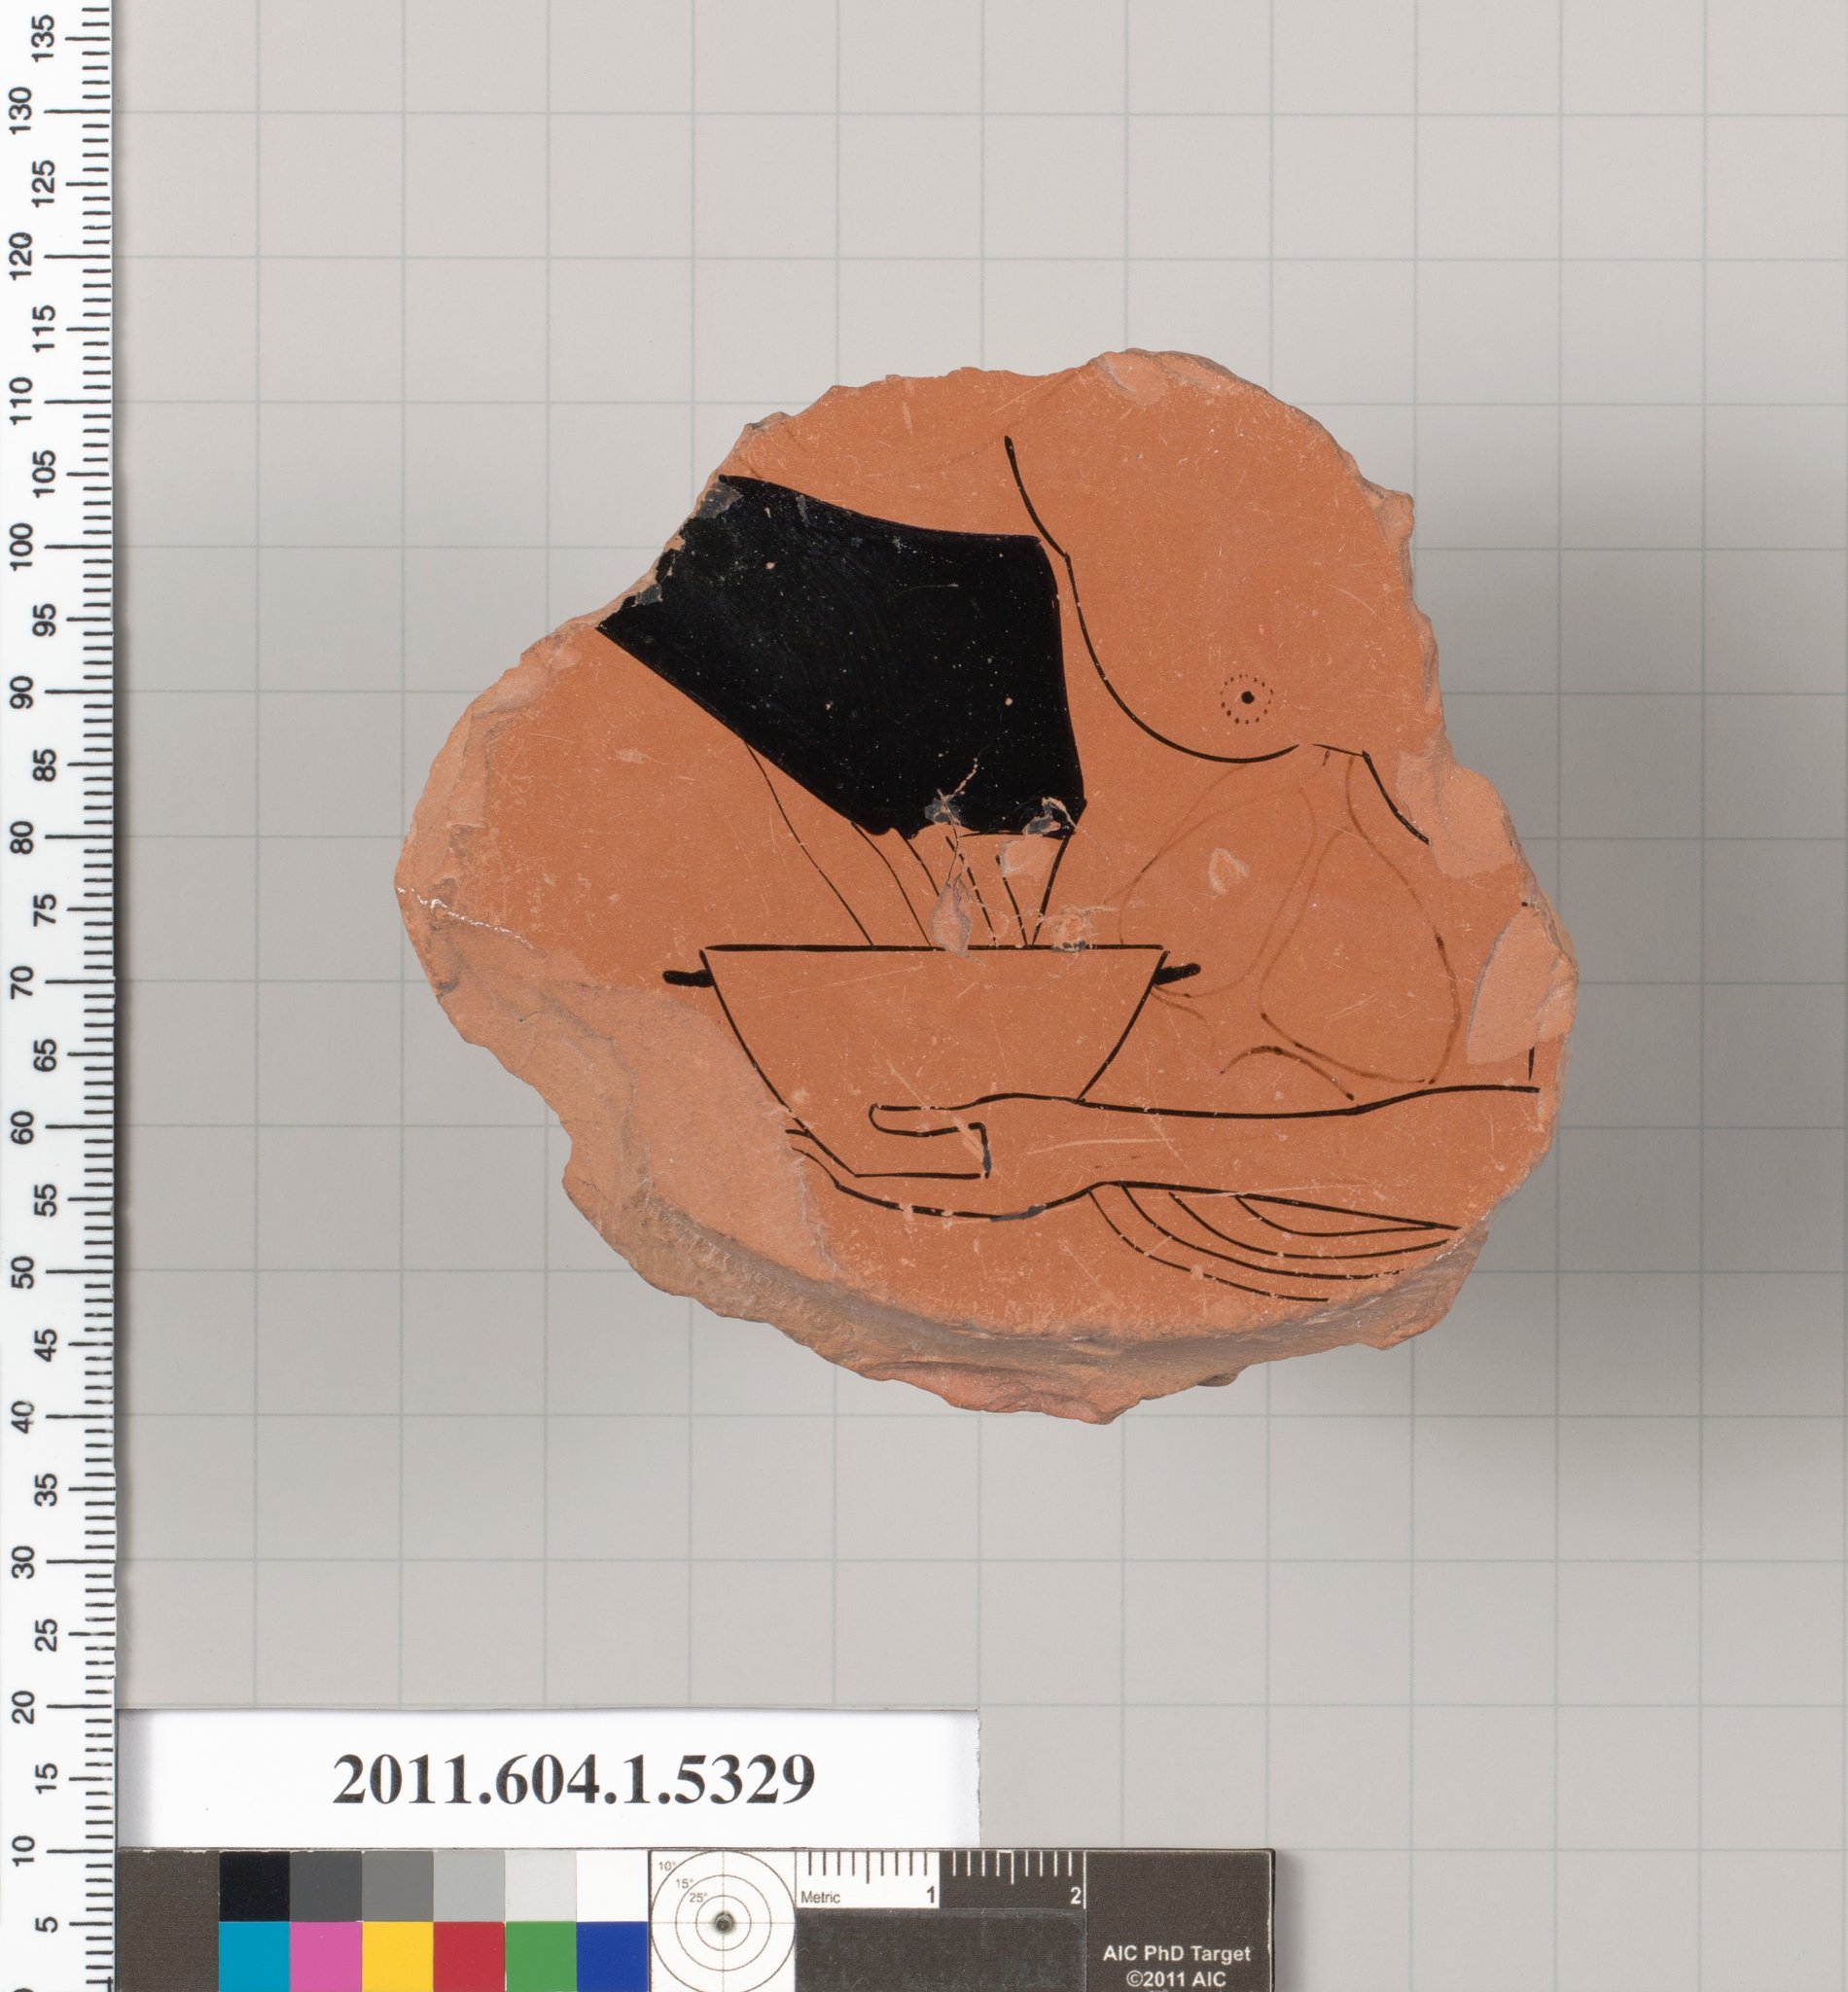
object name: kylix fragment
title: Terracotta fragment of a kylix (drinking cup)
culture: greek, attic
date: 520-500 BCE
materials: terracotta